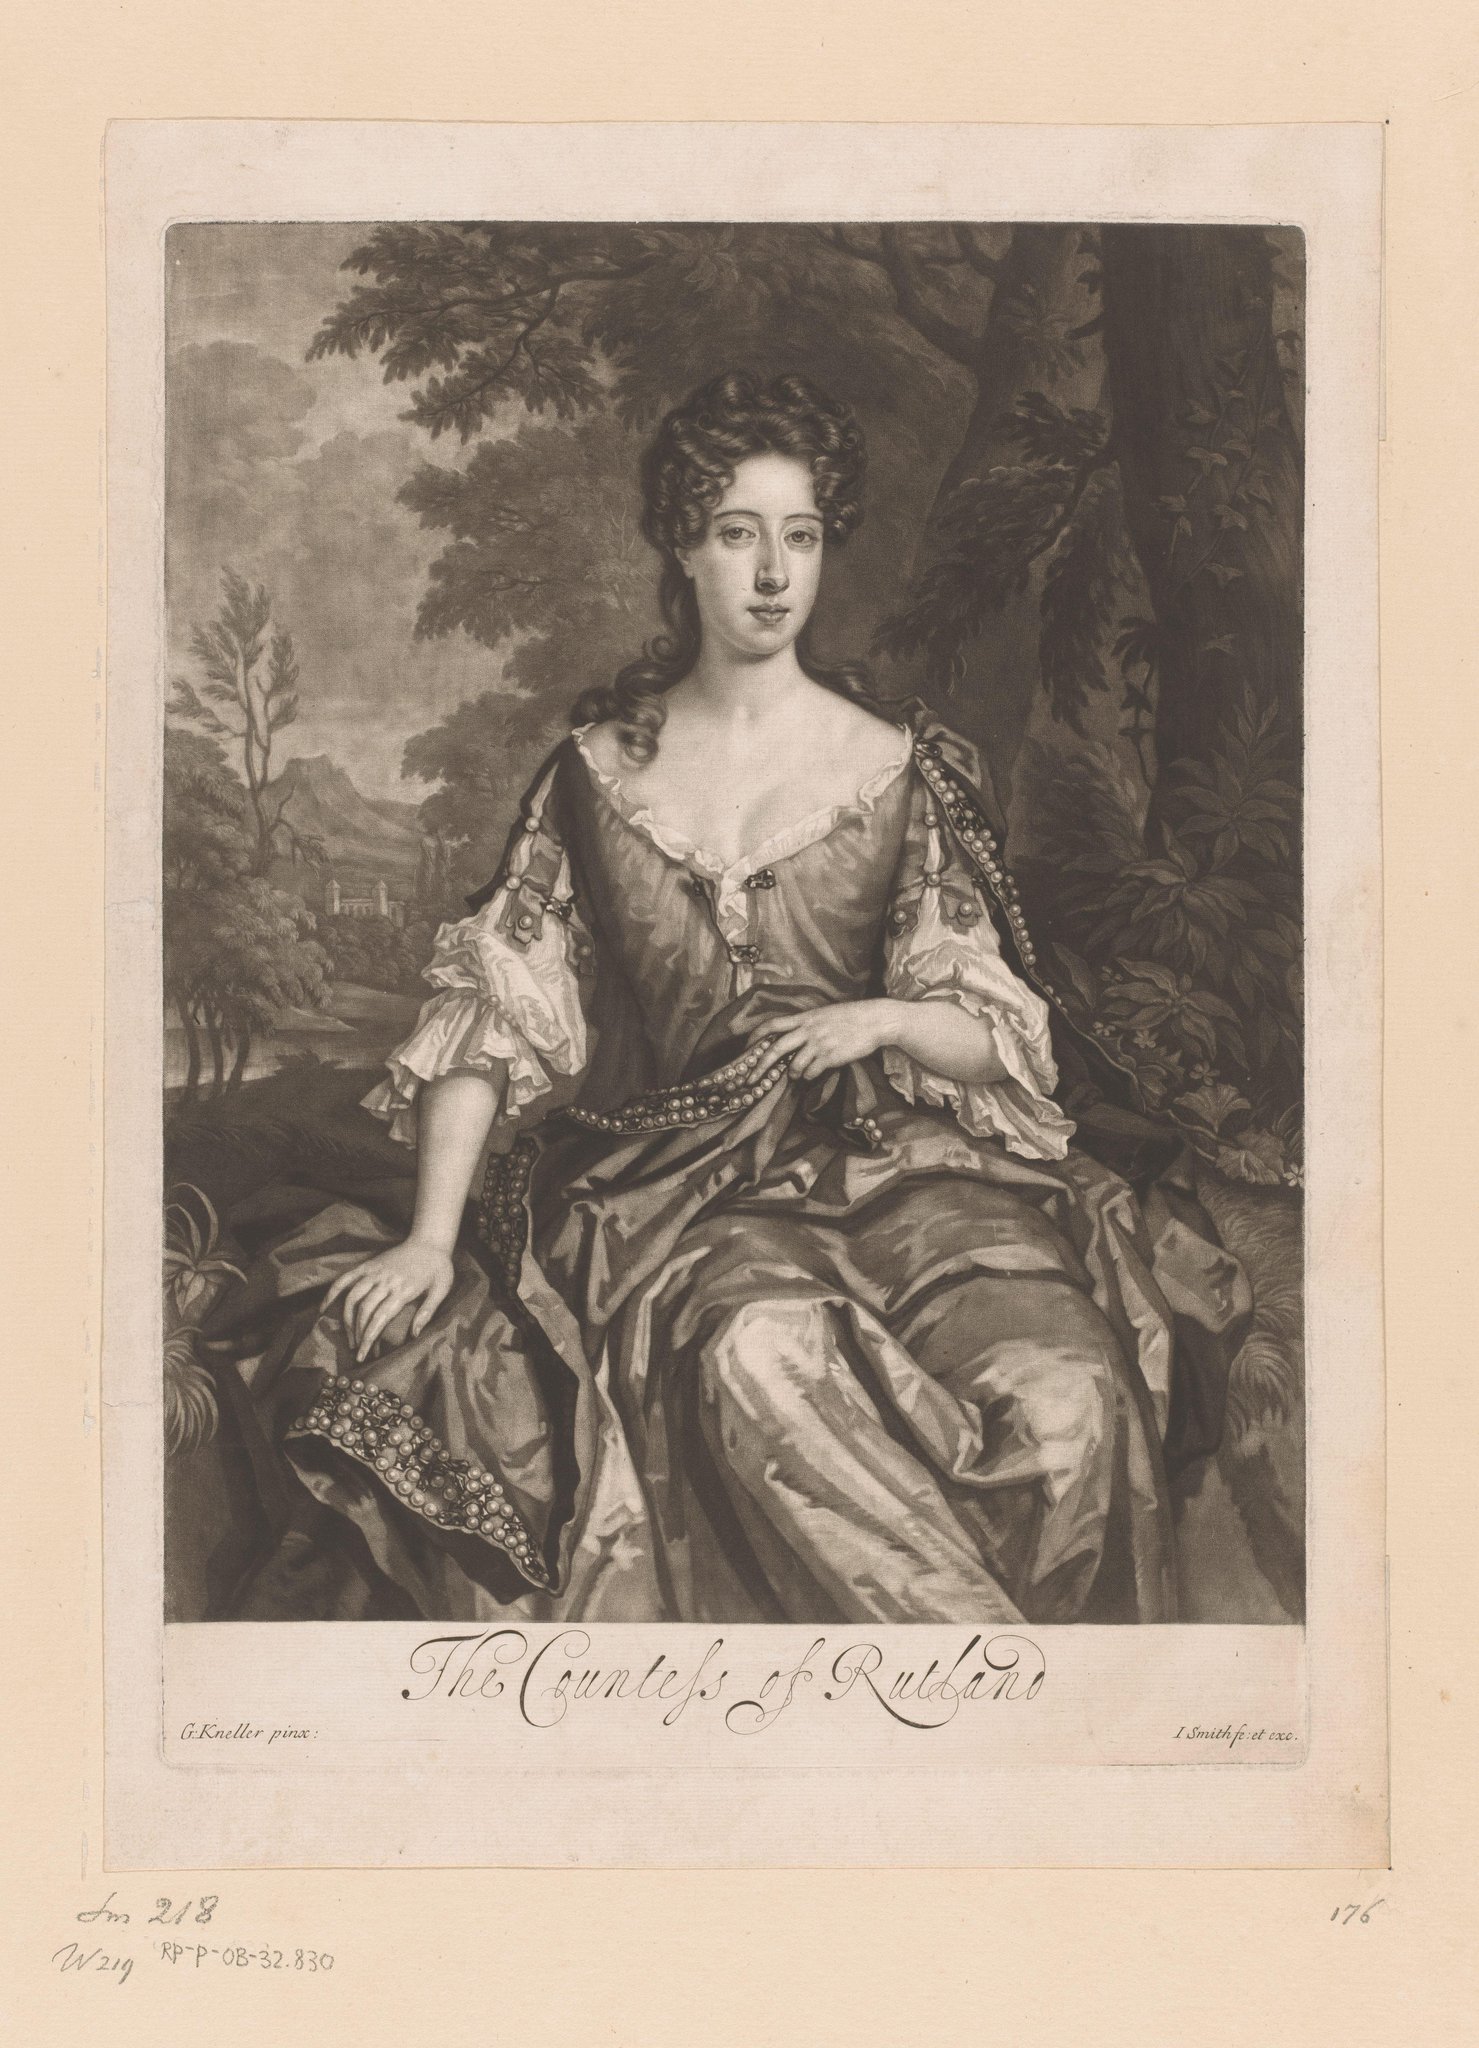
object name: print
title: The Countess of Rutland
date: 1662-1742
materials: paper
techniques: mezzotint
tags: historical persons, ornaments, jewels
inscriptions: collector's mark: Lugt 240